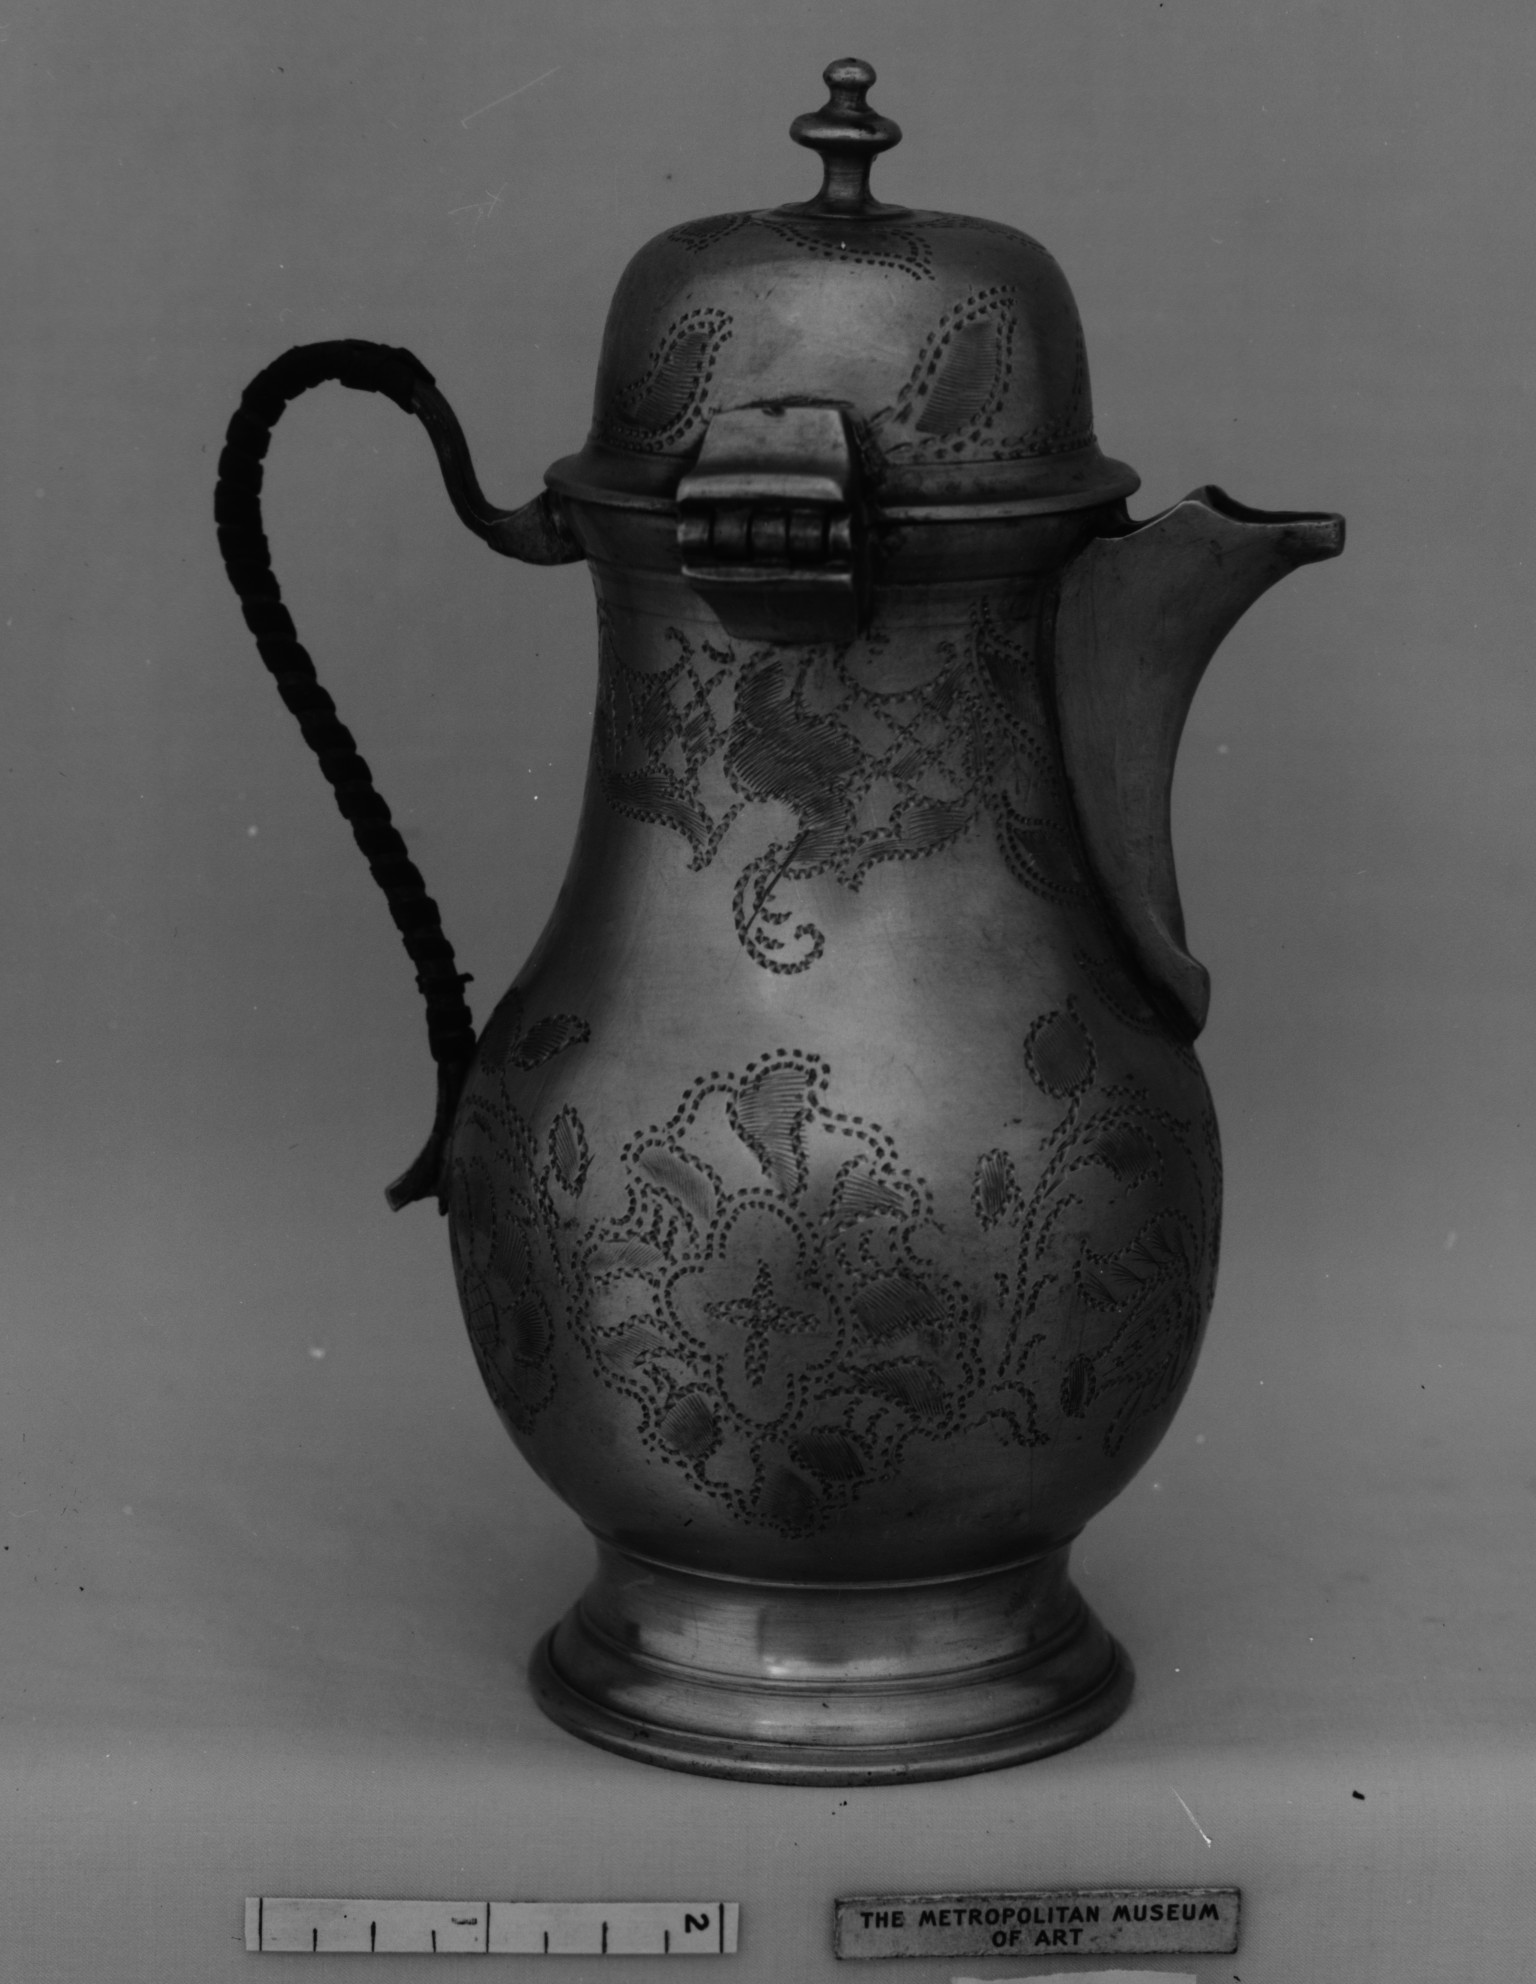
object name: coffeepot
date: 1701-1733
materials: pewter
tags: flowers